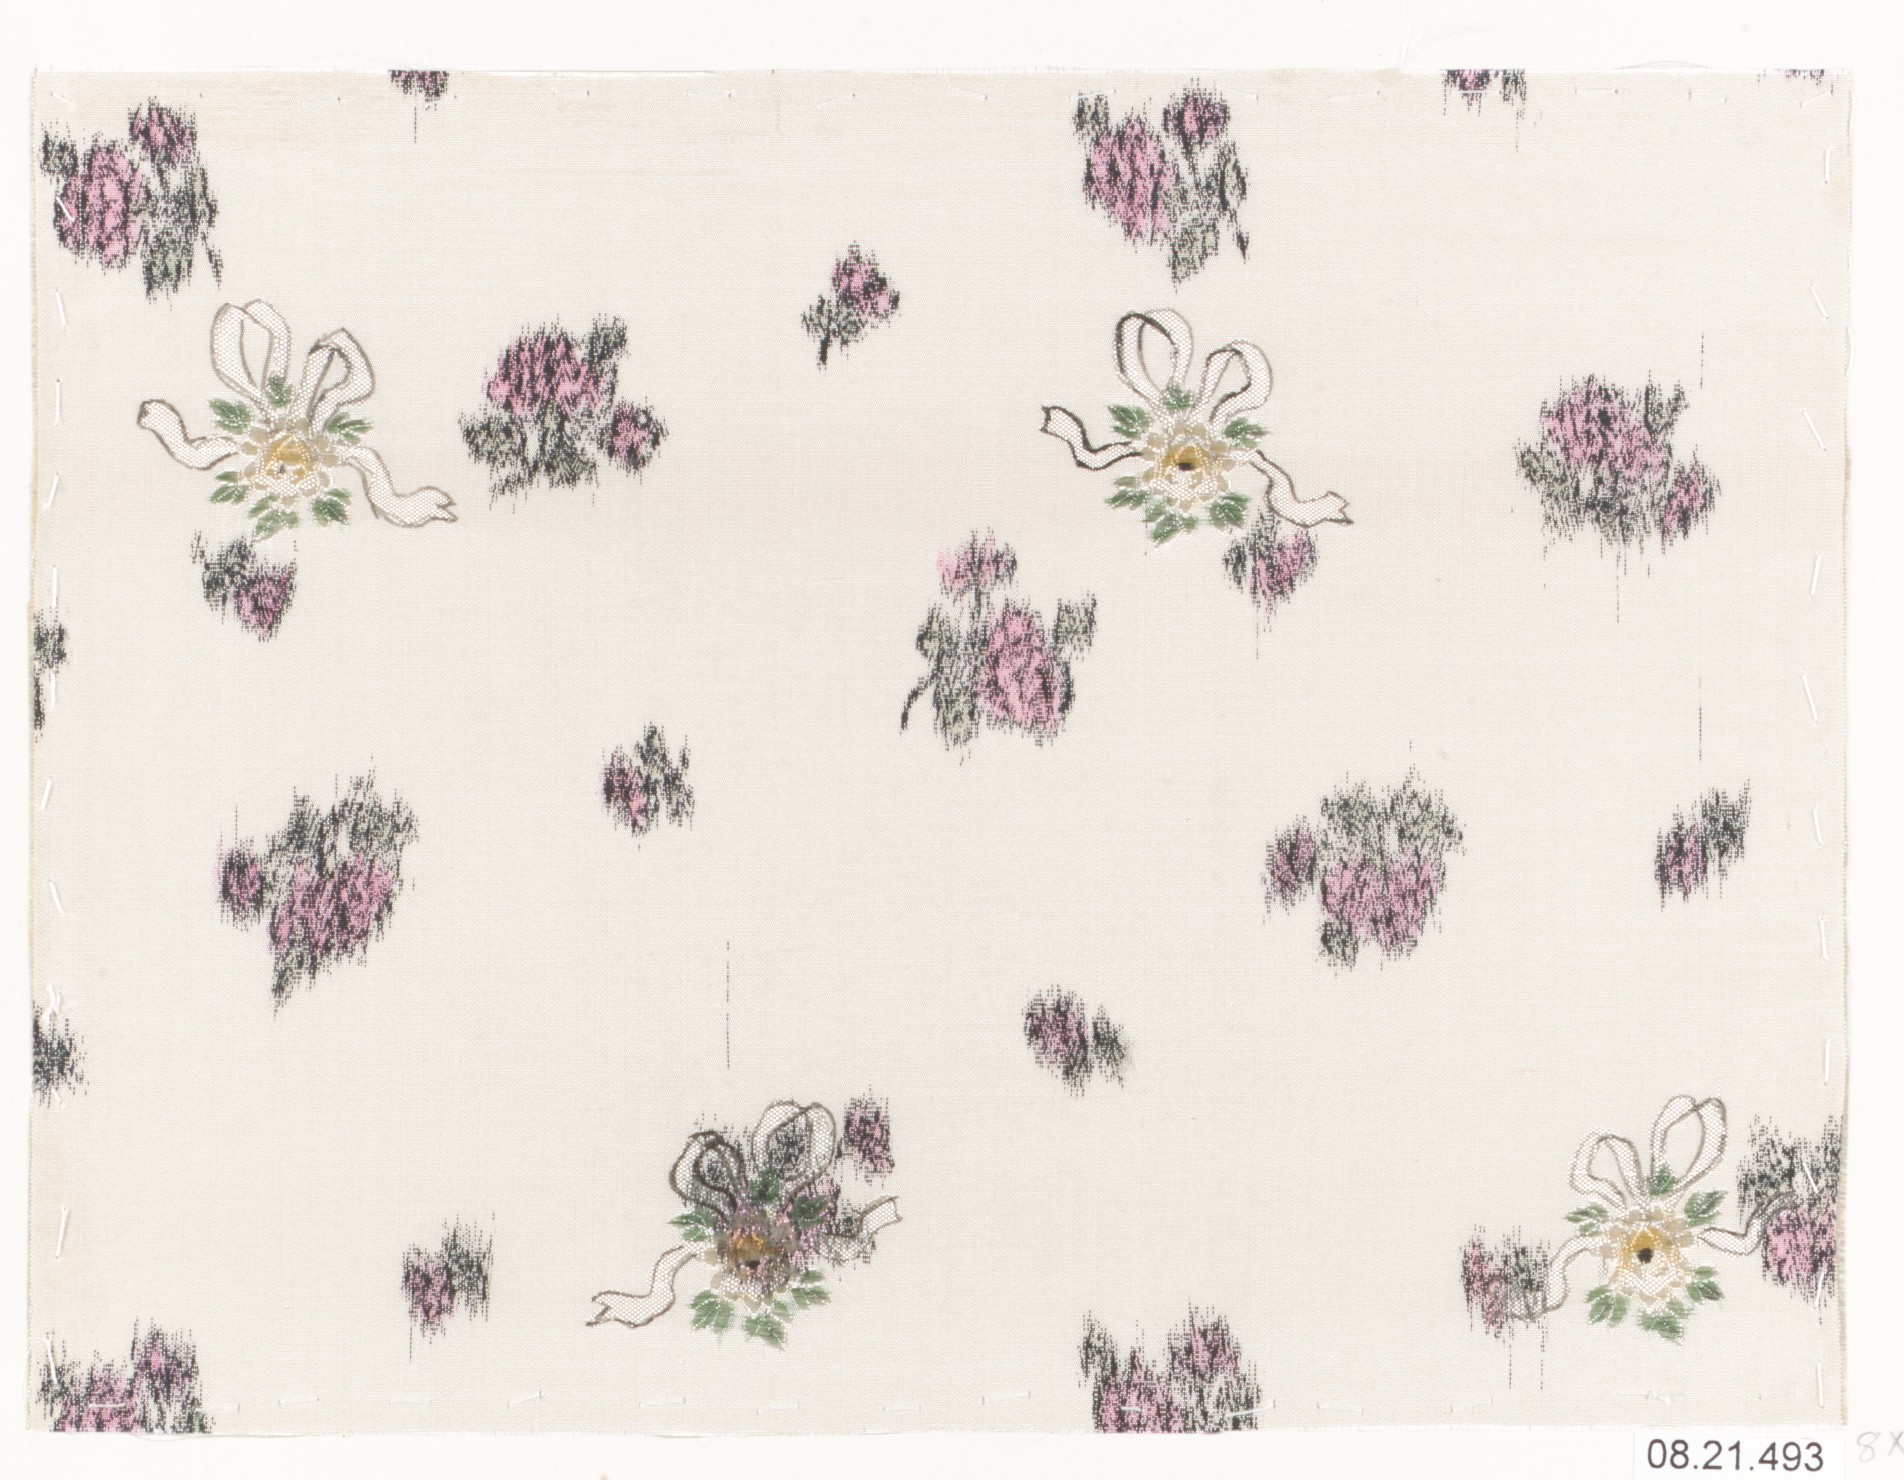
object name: textile sample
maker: Anonymous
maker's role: designer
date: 1900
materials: silk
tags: flowers